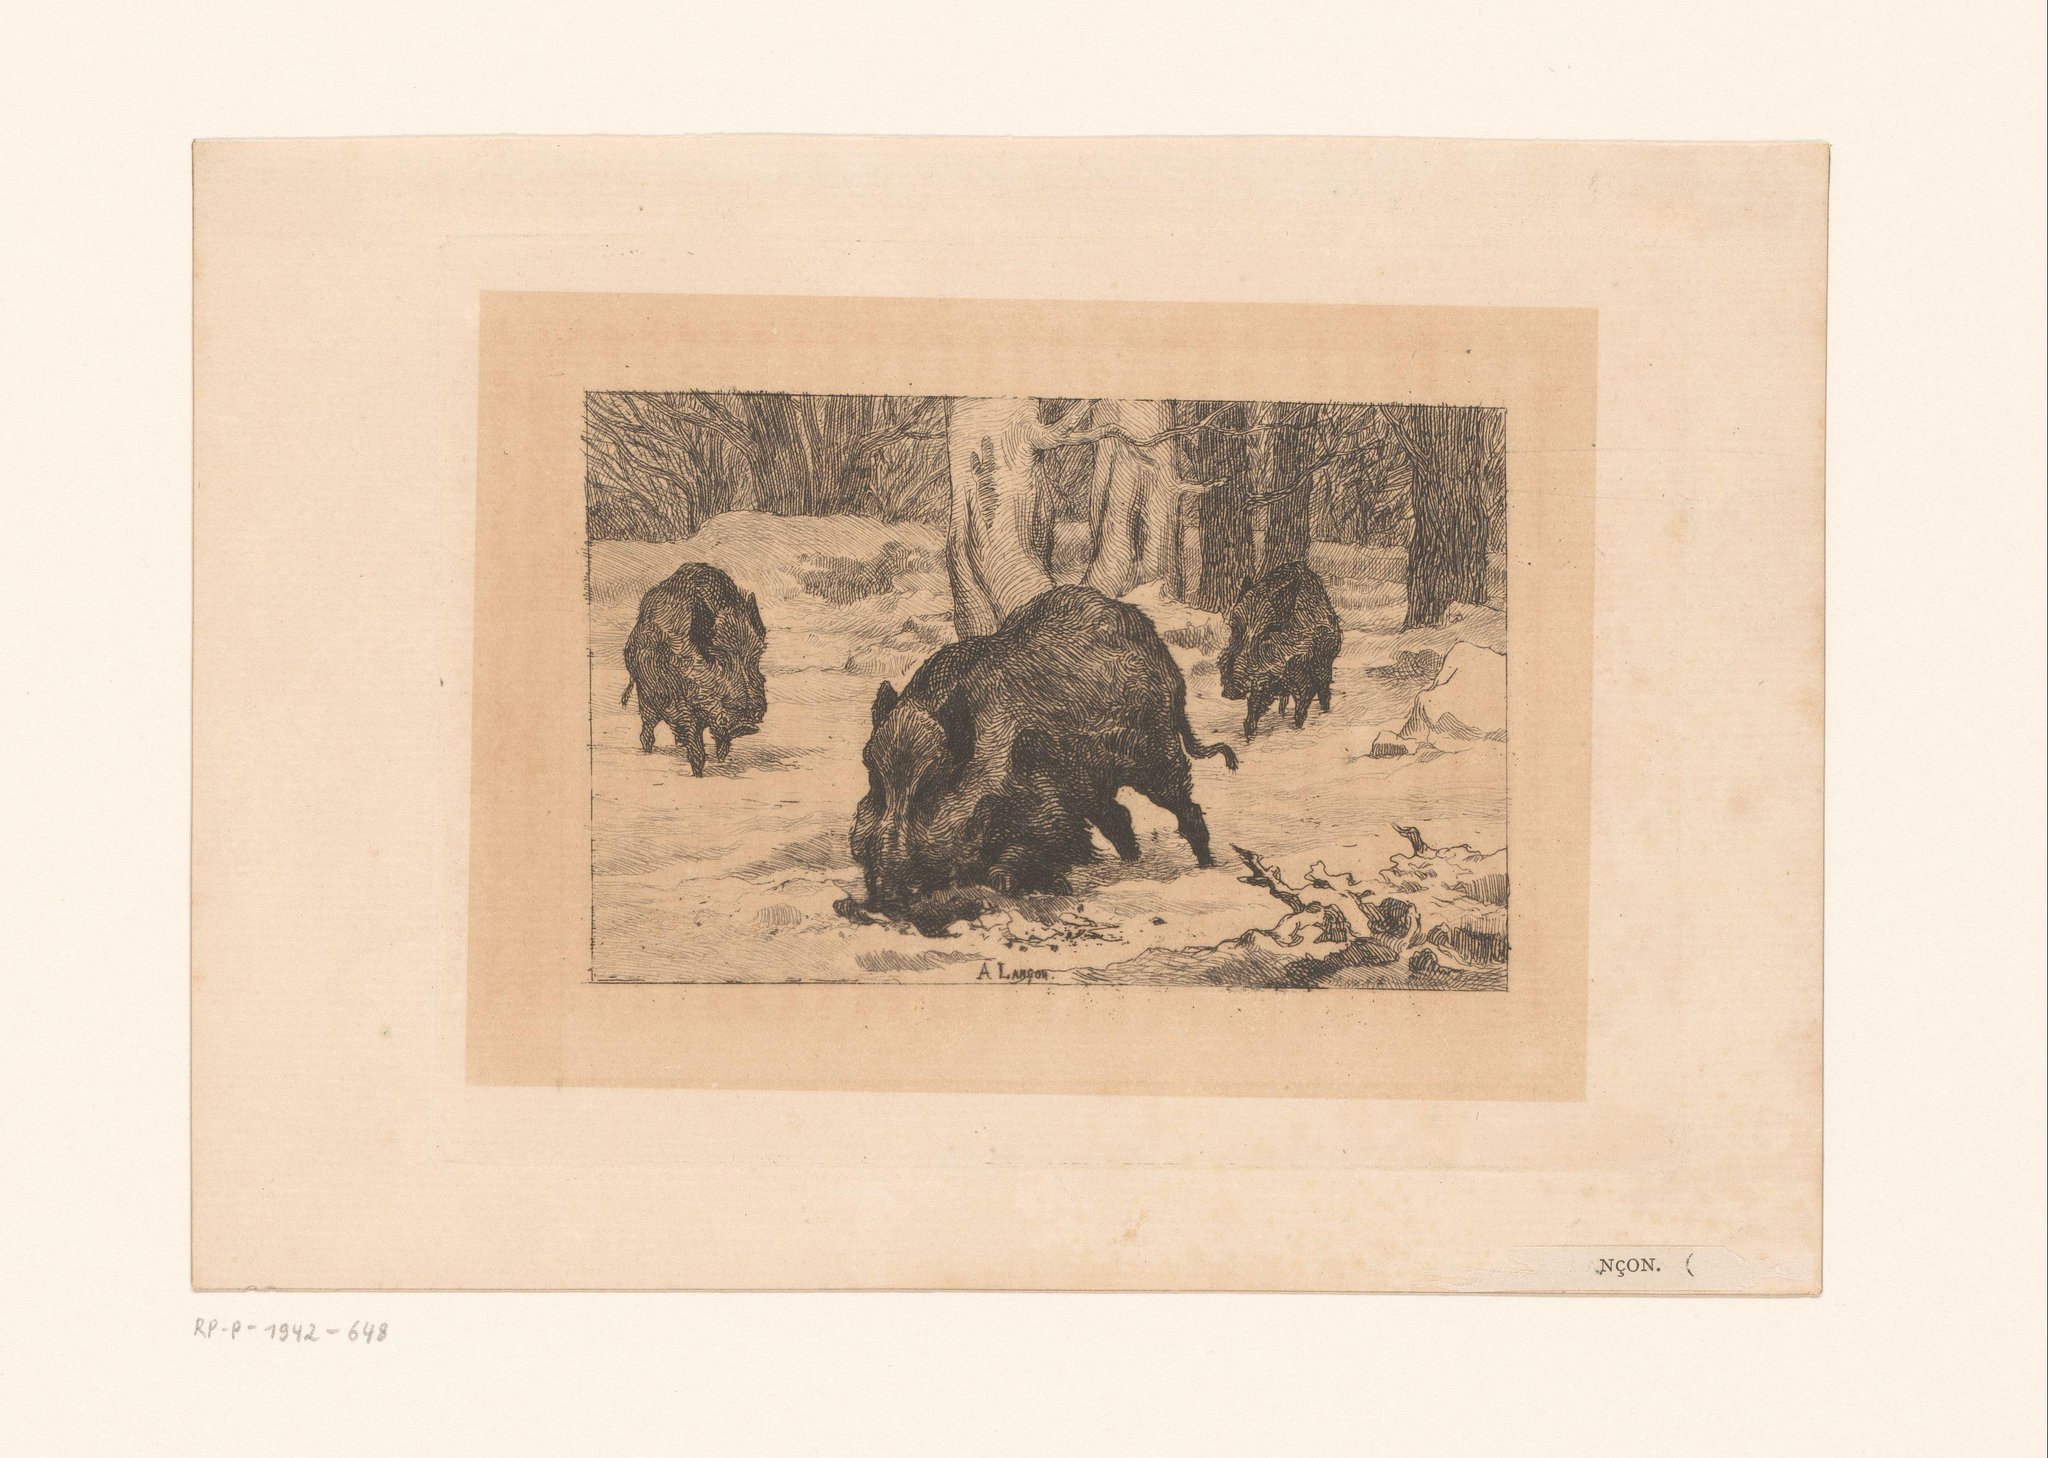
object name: print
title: Everzwijnen in een bos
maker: auguste andré lançon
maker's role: print maker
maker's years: 1836-1887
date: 1846-1887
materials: paper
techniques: etching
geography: france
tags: hoofed animals: boar, forest, wood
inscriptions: collector's mark: Lugt 2228